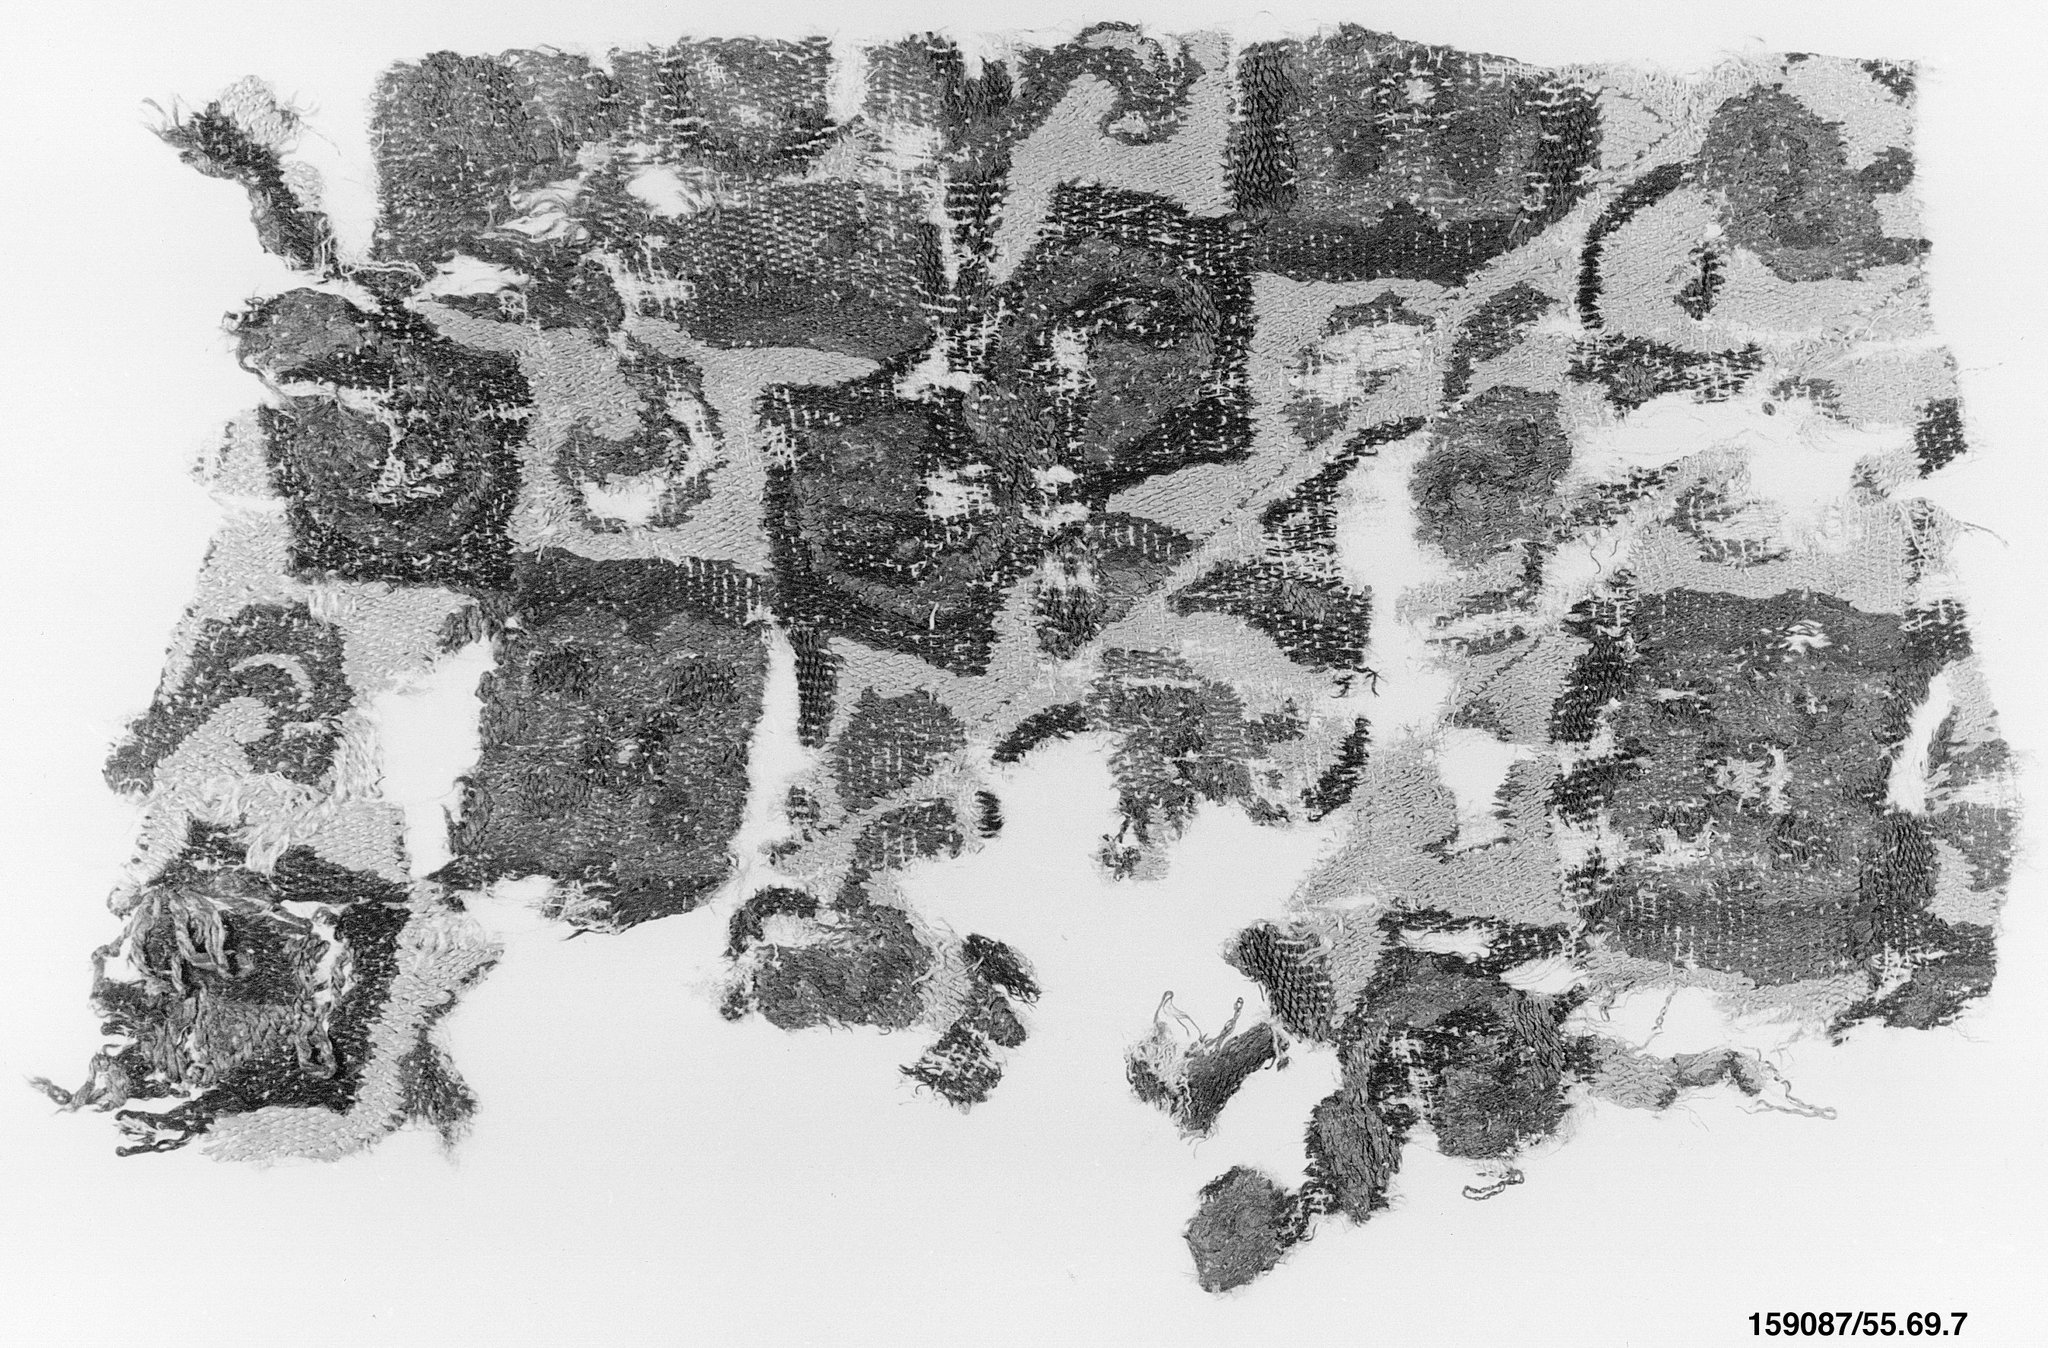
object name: textile fragment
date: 701-900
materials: cotton, silk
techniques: embroidery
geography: egypt